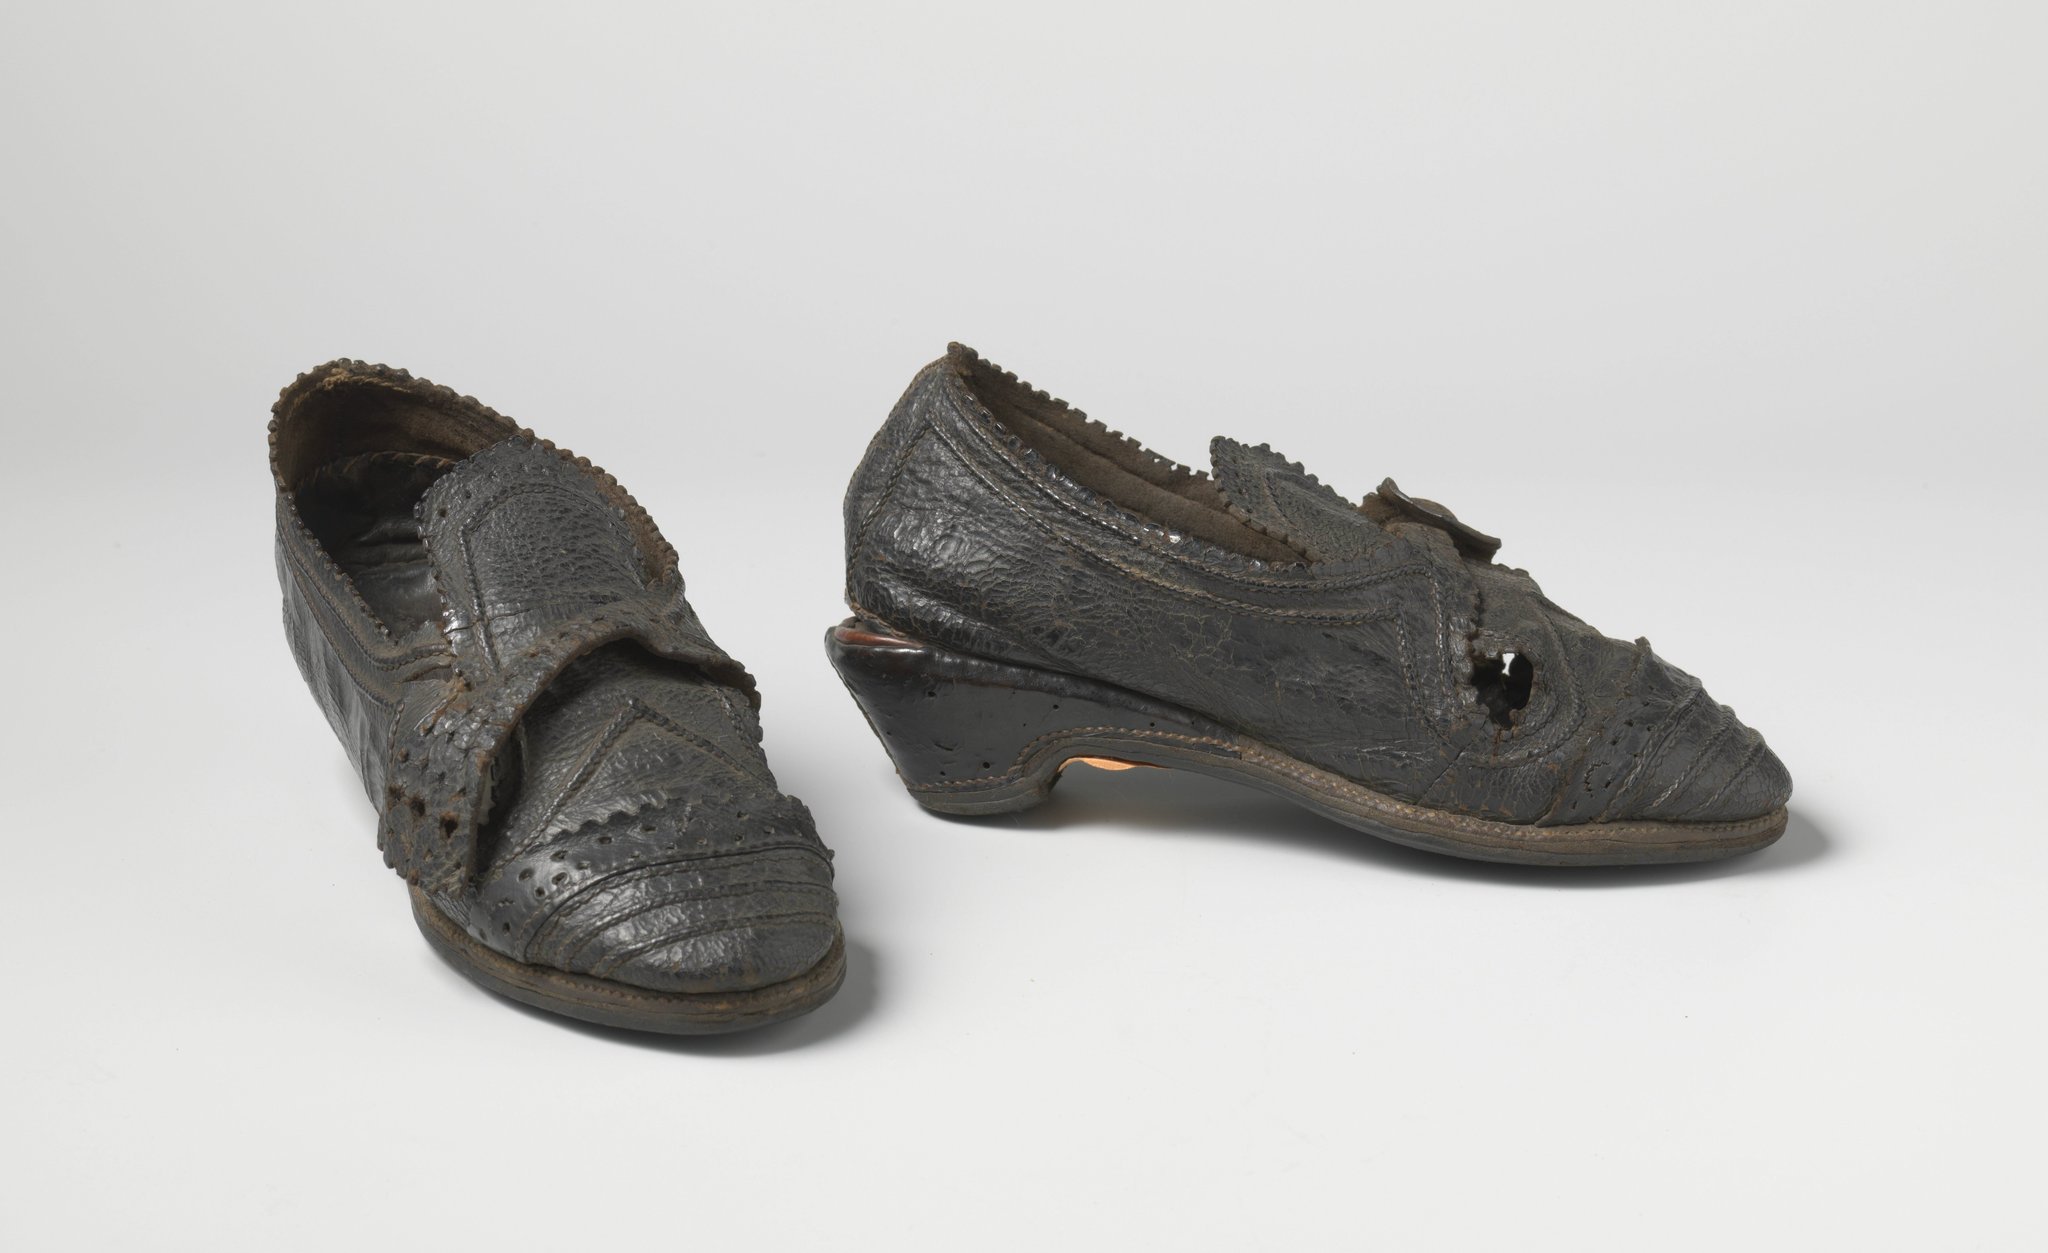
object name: womenswear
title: Damesschoen van runderleer met opstaande tong, versierd met perforaties en kartels, voorzien van lage hak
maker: Anonymous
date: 1600-1650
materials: leather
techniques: perforating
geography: northern netherlands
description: Schoen van zwart leer. Links-rechts symmetrisch. Het voorblad verloopt in een klep, waarover een riem gesloten wordt. De blokhak zit gedeeltelijk los, op welke plaats een bies van rood leer is aangebracht. Versiering van twee oprijgjes, perforaties en uittandingen. (verwant aan BK-NM-8430).